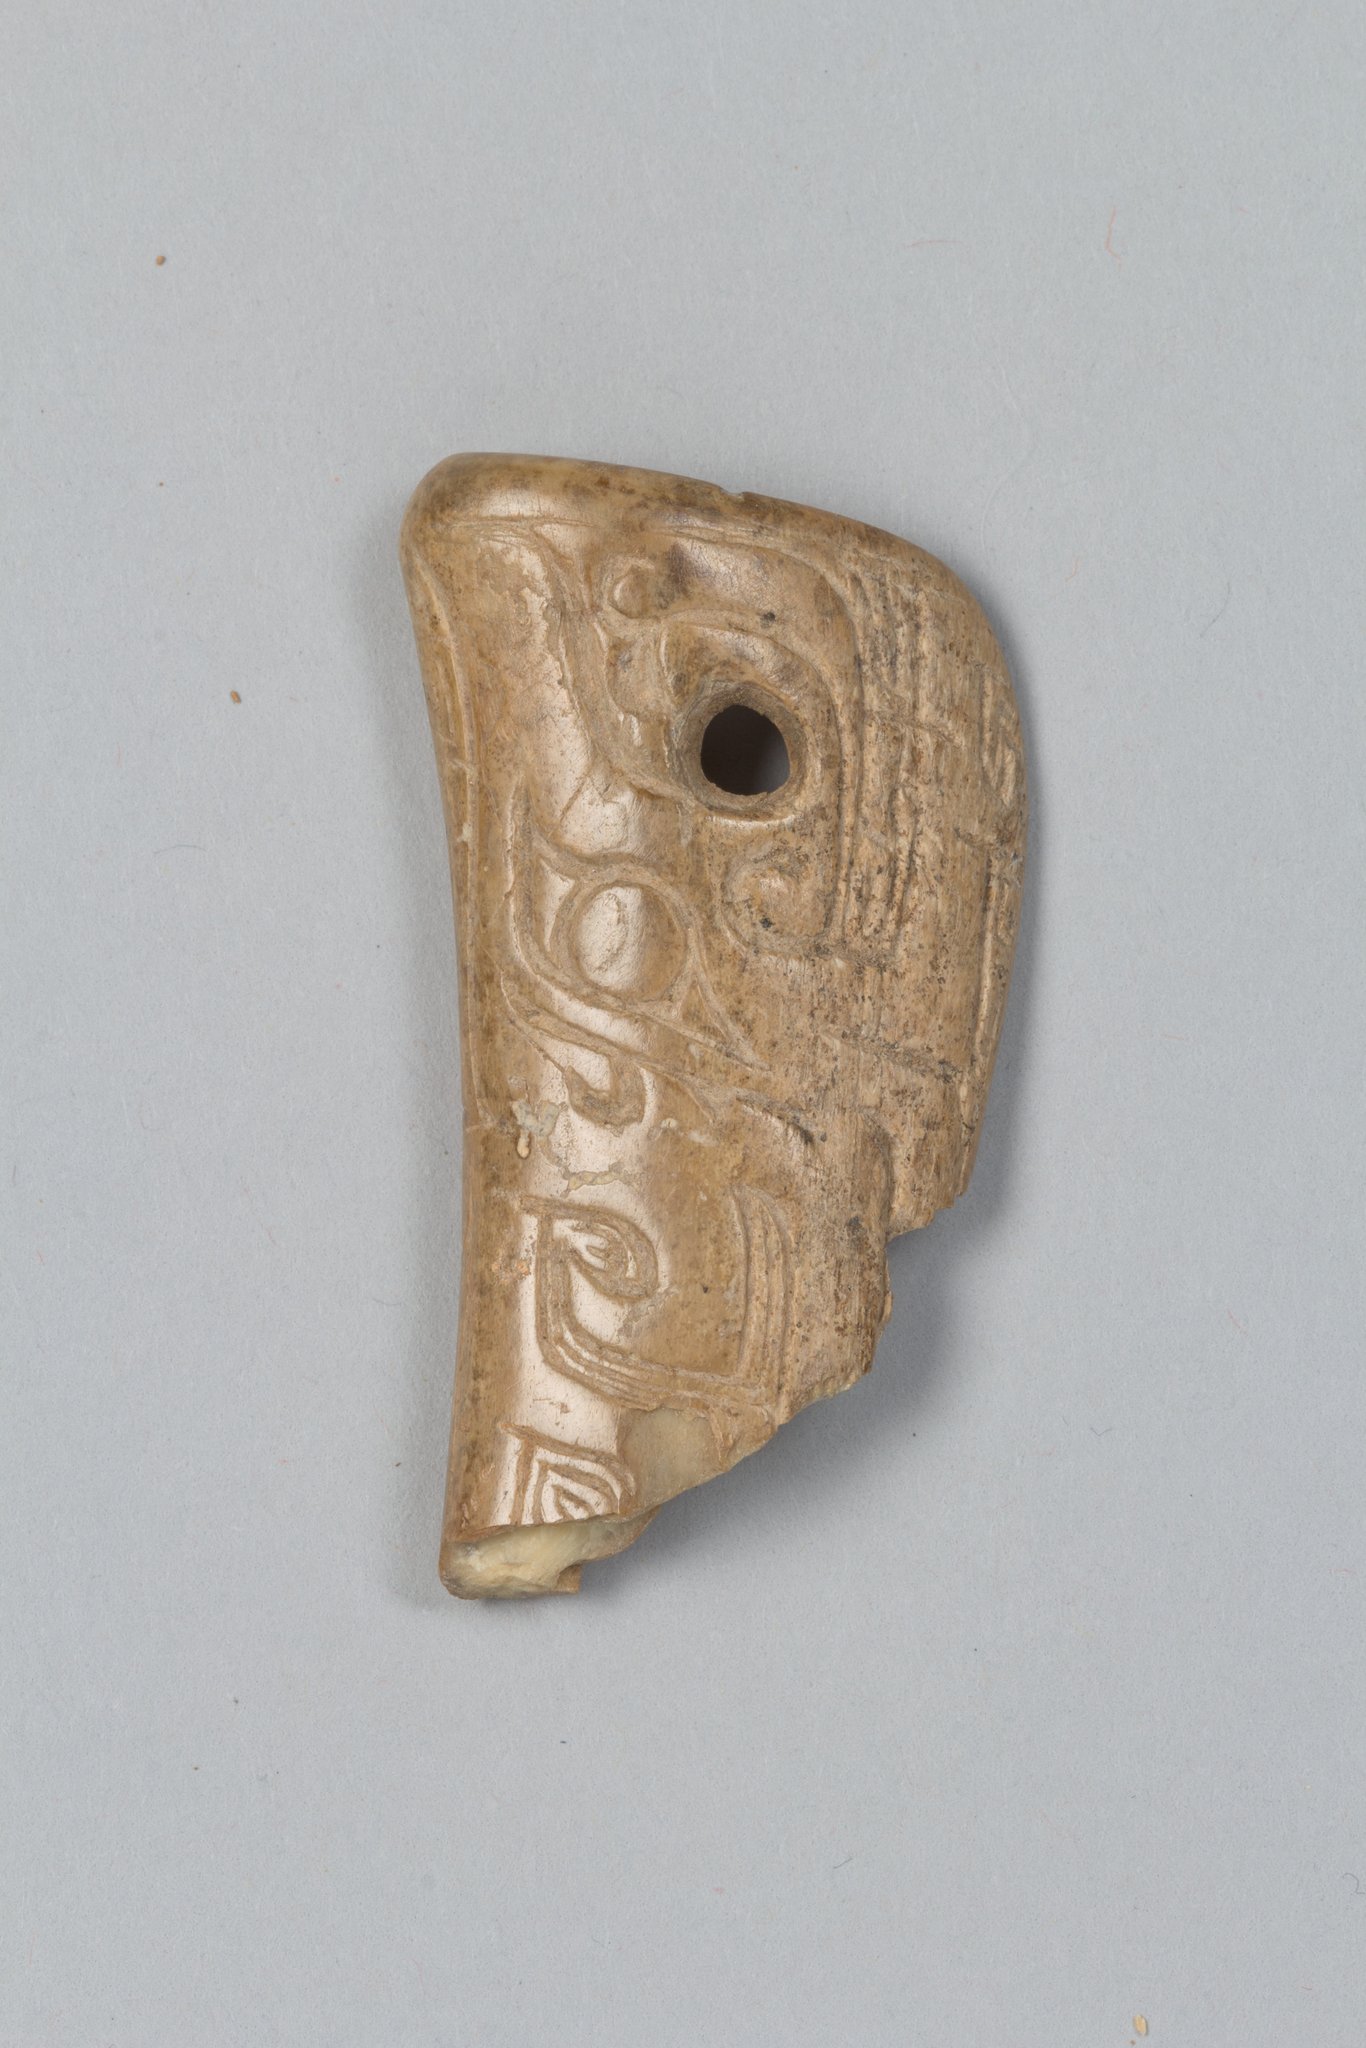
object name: oracle bone fragment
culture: chinese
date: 1600-1046 BCE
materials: bone